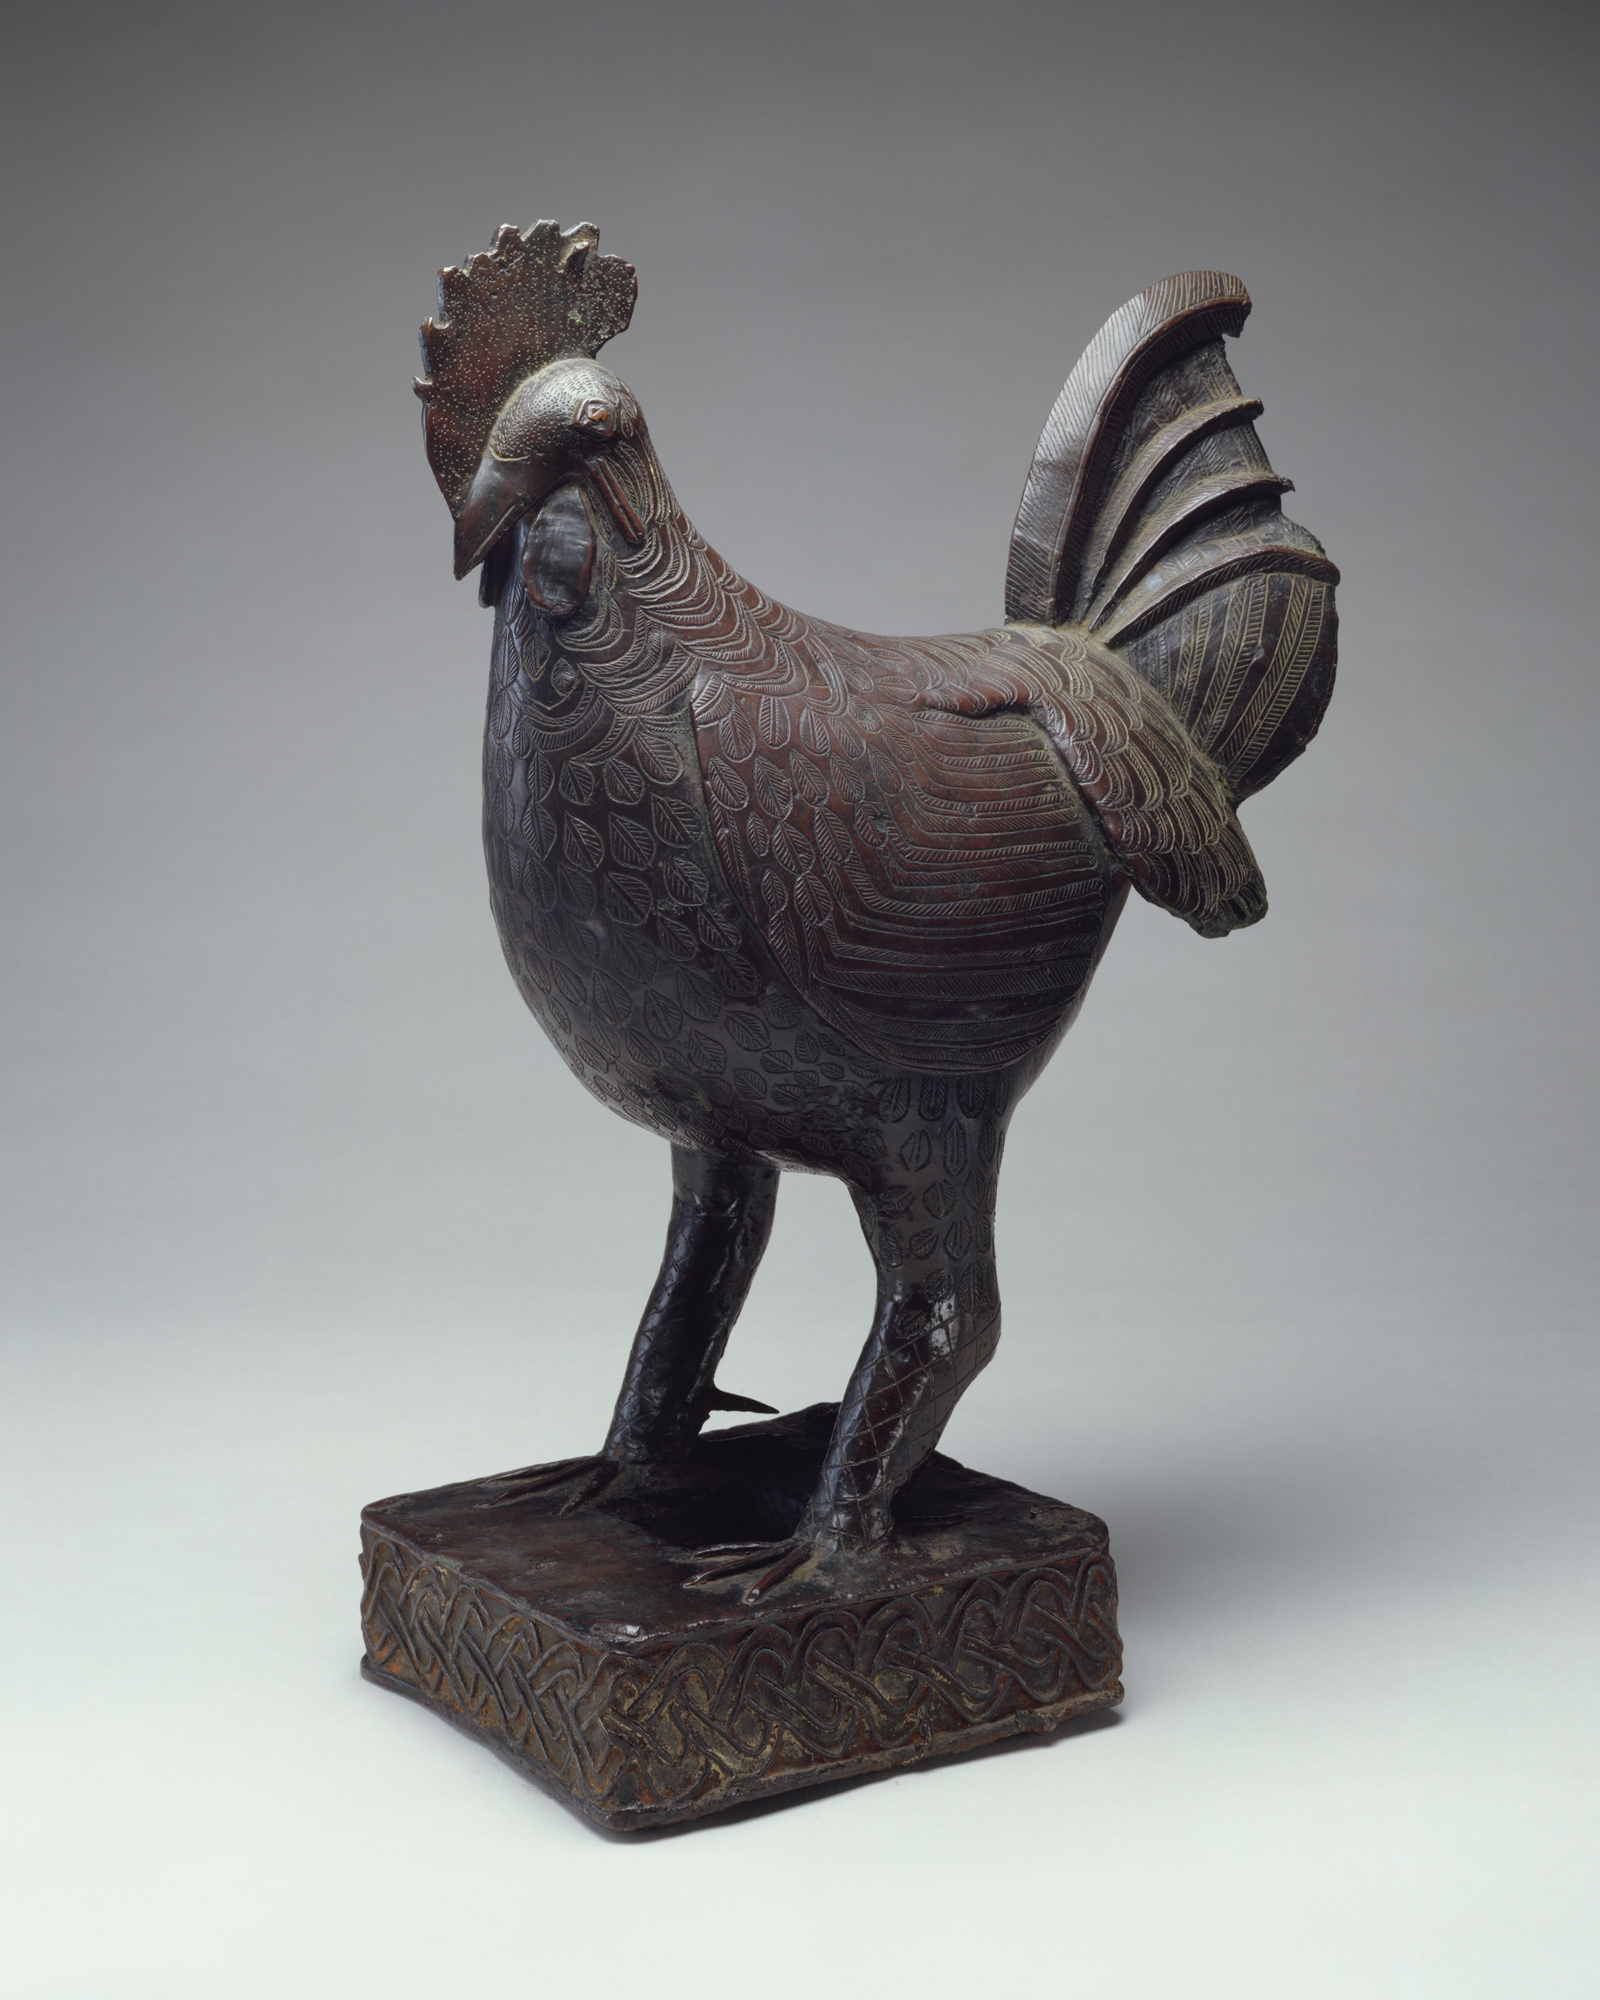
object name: figure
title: Rooster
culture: edo period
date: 1701-1800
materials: brass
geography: nigeria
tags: roosters